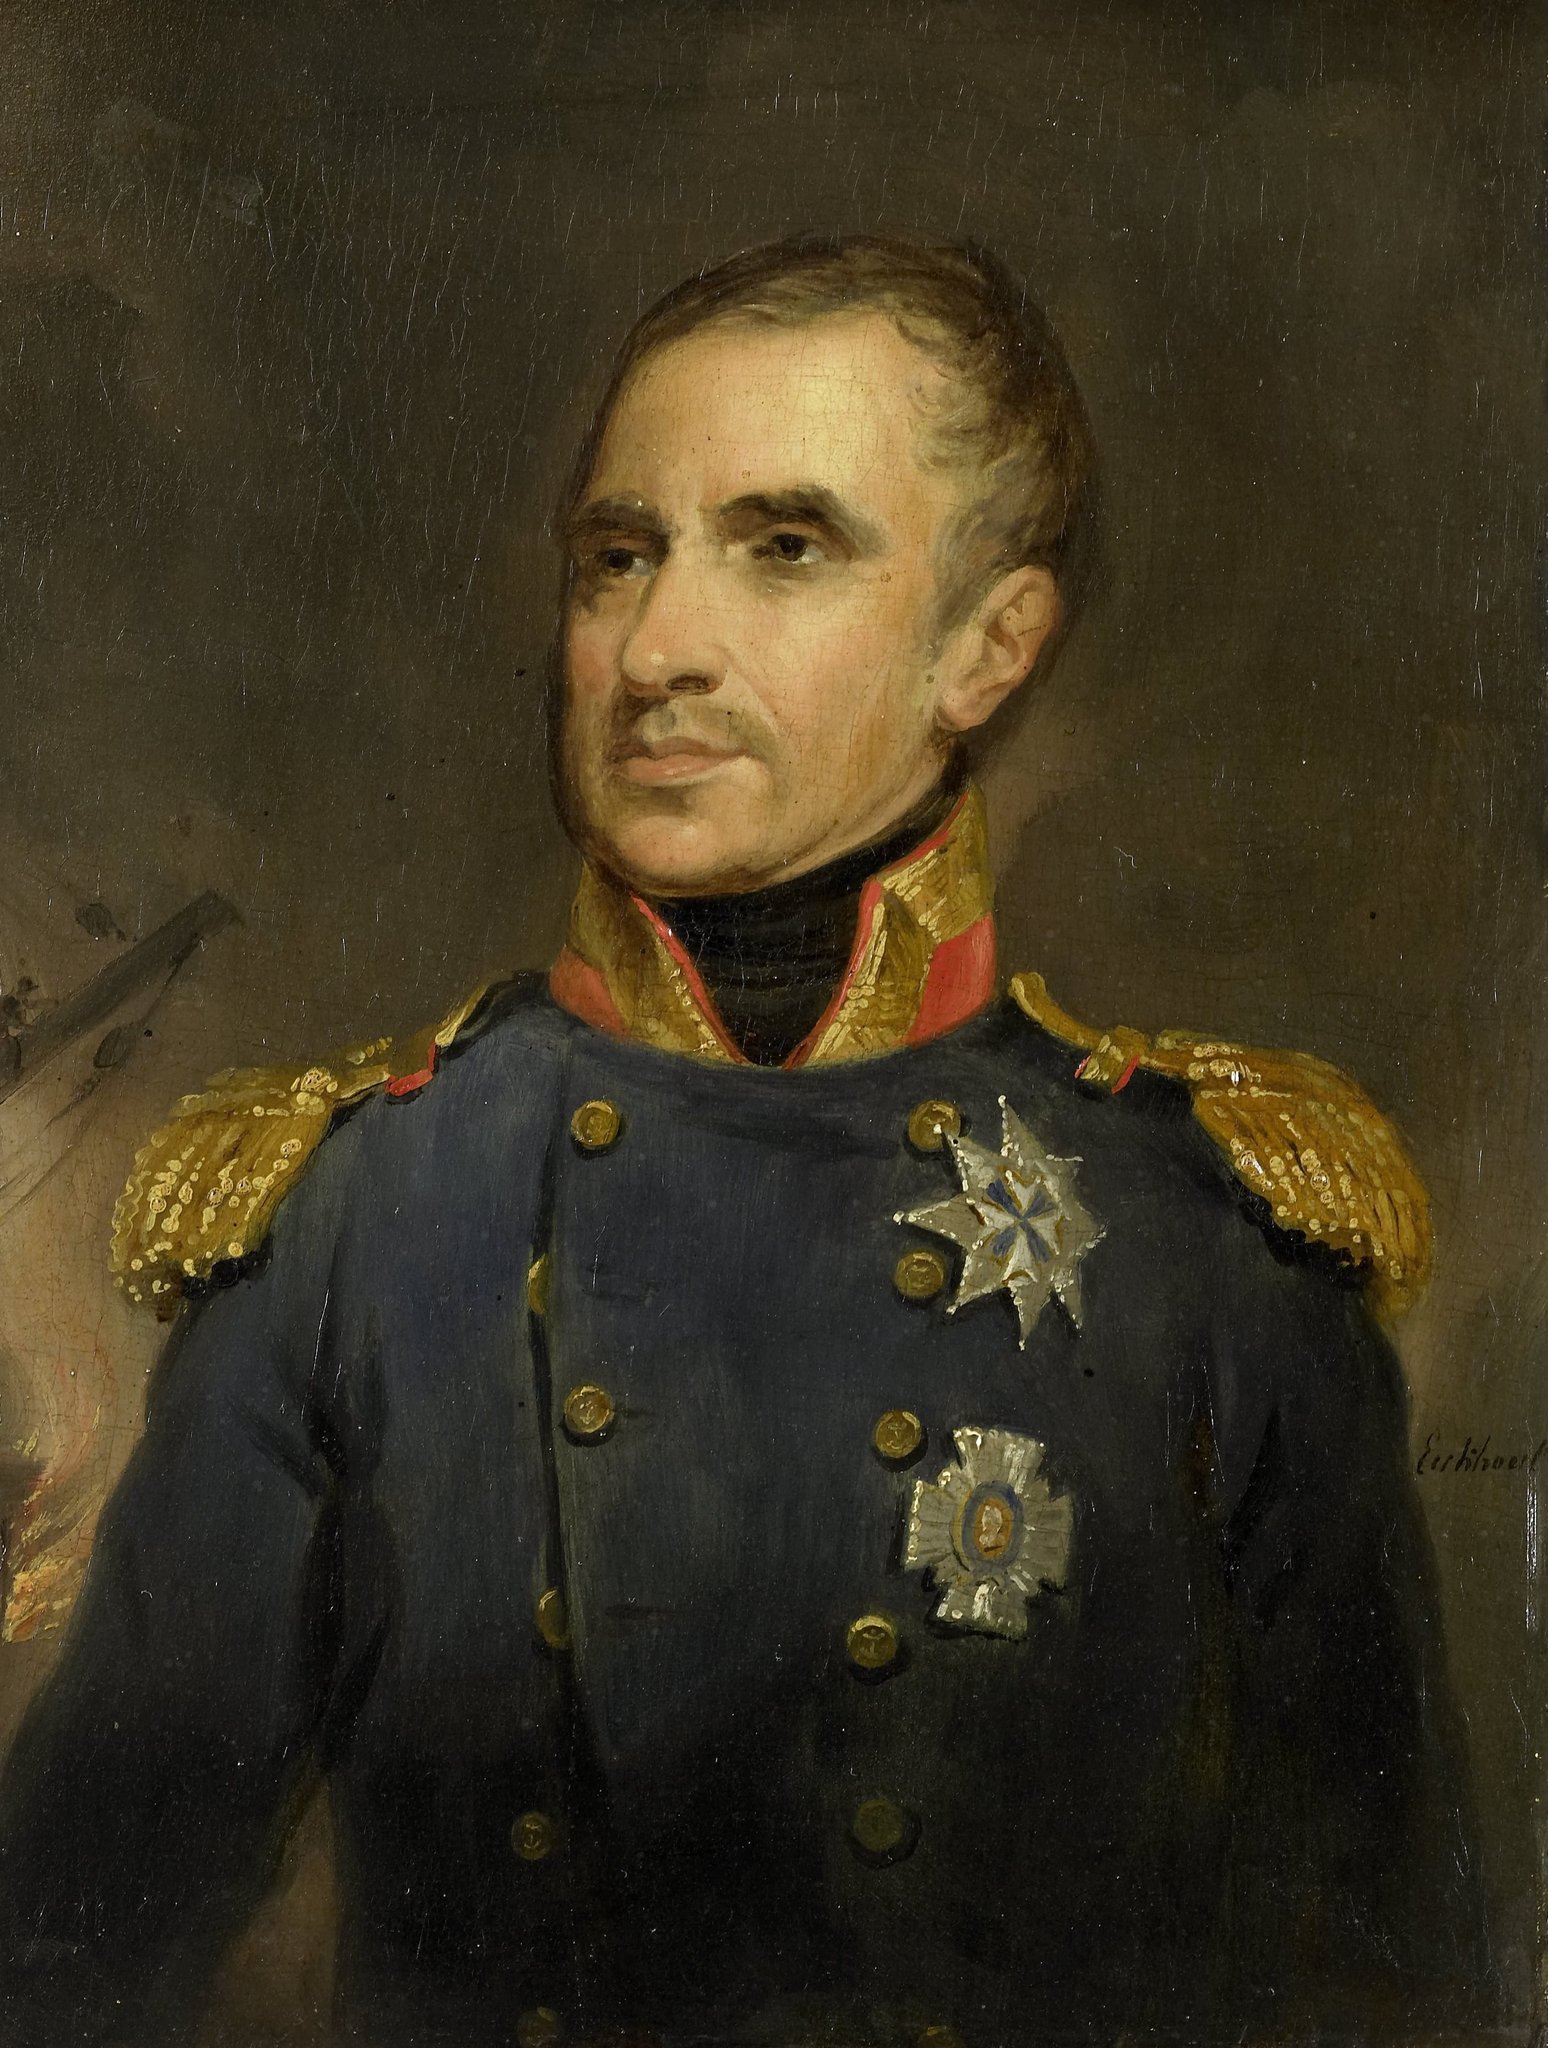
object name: painting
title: Jonkheer Theodorus Frederik van Capellen (1762-1824), Vice Admiral and Commanding Officer of the Dutch Squadron off Algiers, 1816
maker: jacob joseph eeckhout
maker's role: draughtsman, print maker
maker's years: 1793-1861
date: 1835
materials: oil, panel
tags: nijmegen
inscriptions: signature: ‘Eeckhout’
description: Portret van jonkheer Theodorus Frederik van Capellen, vice-admiraal en bevelhebber van het Nederlandse eskader voor Algiers in 1816. Borstbeeld in uniform, met op de borst de decoraties Grootkruis Militaire Willemsorde en de Bath-order. Kopie naar het pastel van Charles Howard Hodges SK-A-4639. Pendant van SK-A-4055.